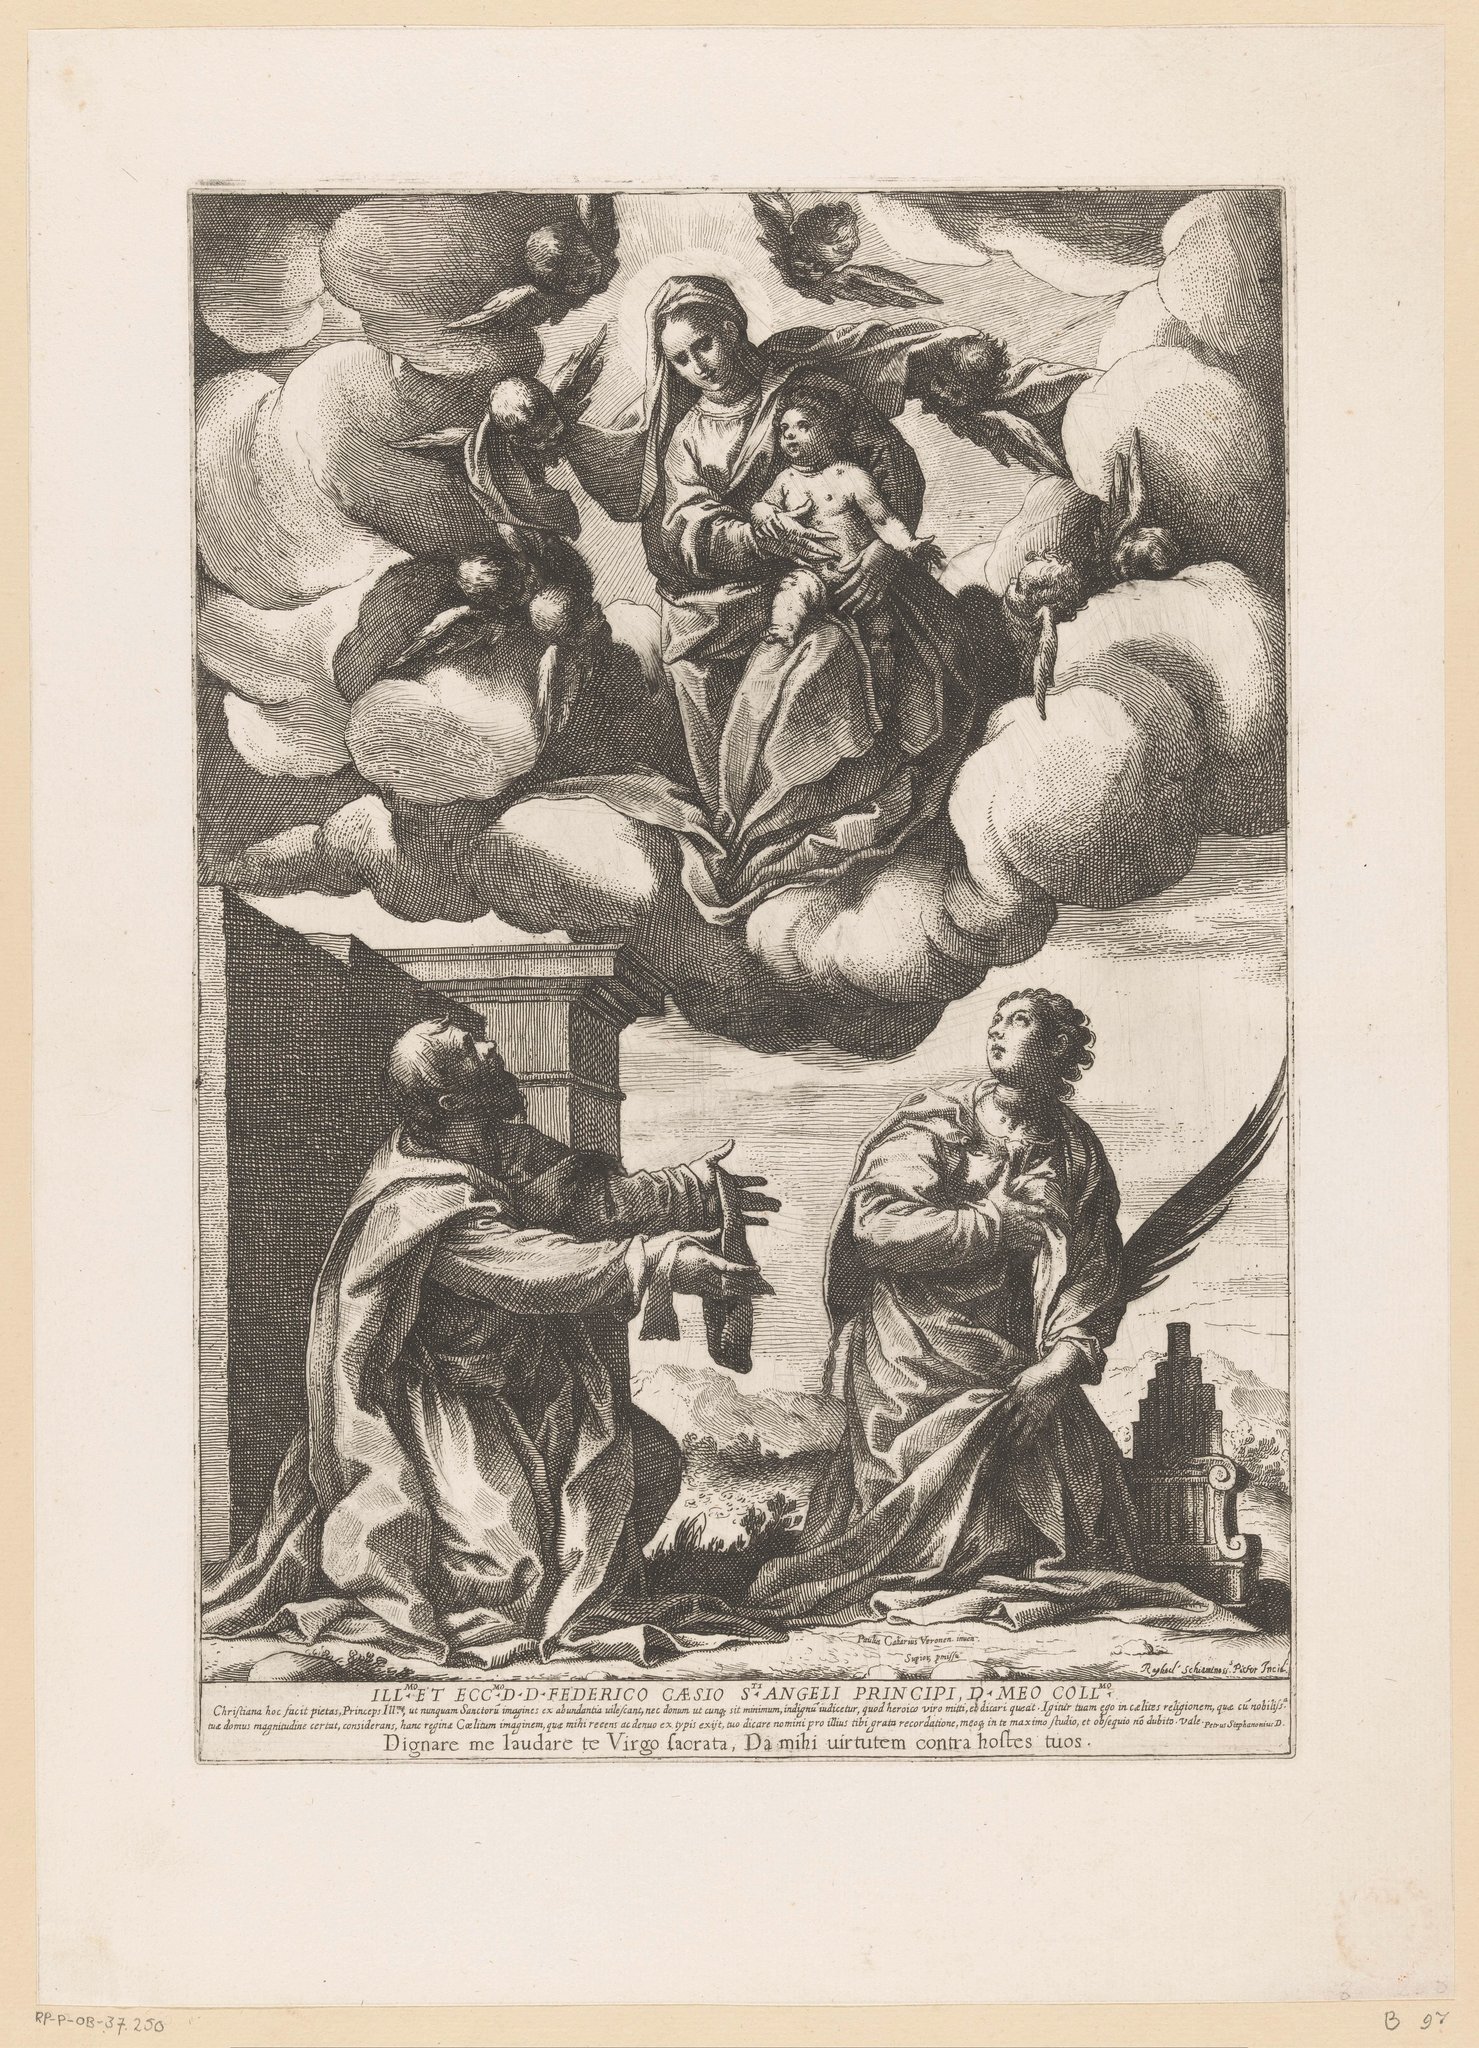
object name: print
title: Maria met Kind aanbeden door de heiligen Thomas en Cecilia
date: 1613-1627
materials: paper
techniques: etching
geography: italy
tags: the virgin martyr cecilia of rome; possible attributes: falcon, musical instruments, organ, wreath of roses and lilies, cherubs, i.e. children's heads with wings, madonna (i.e. mary with the christ-child) in the air, or on the clouds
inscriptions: collector's mark: Lugt 240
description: Maria met het Christuskind te midden van wolken en cherubijnen. Daaronder knielen de heilige Thomas en de heilige Cecilia met een palmtak en een portatief orgel. Opdracht en drie regels Latijnse tekst in ondermarge.